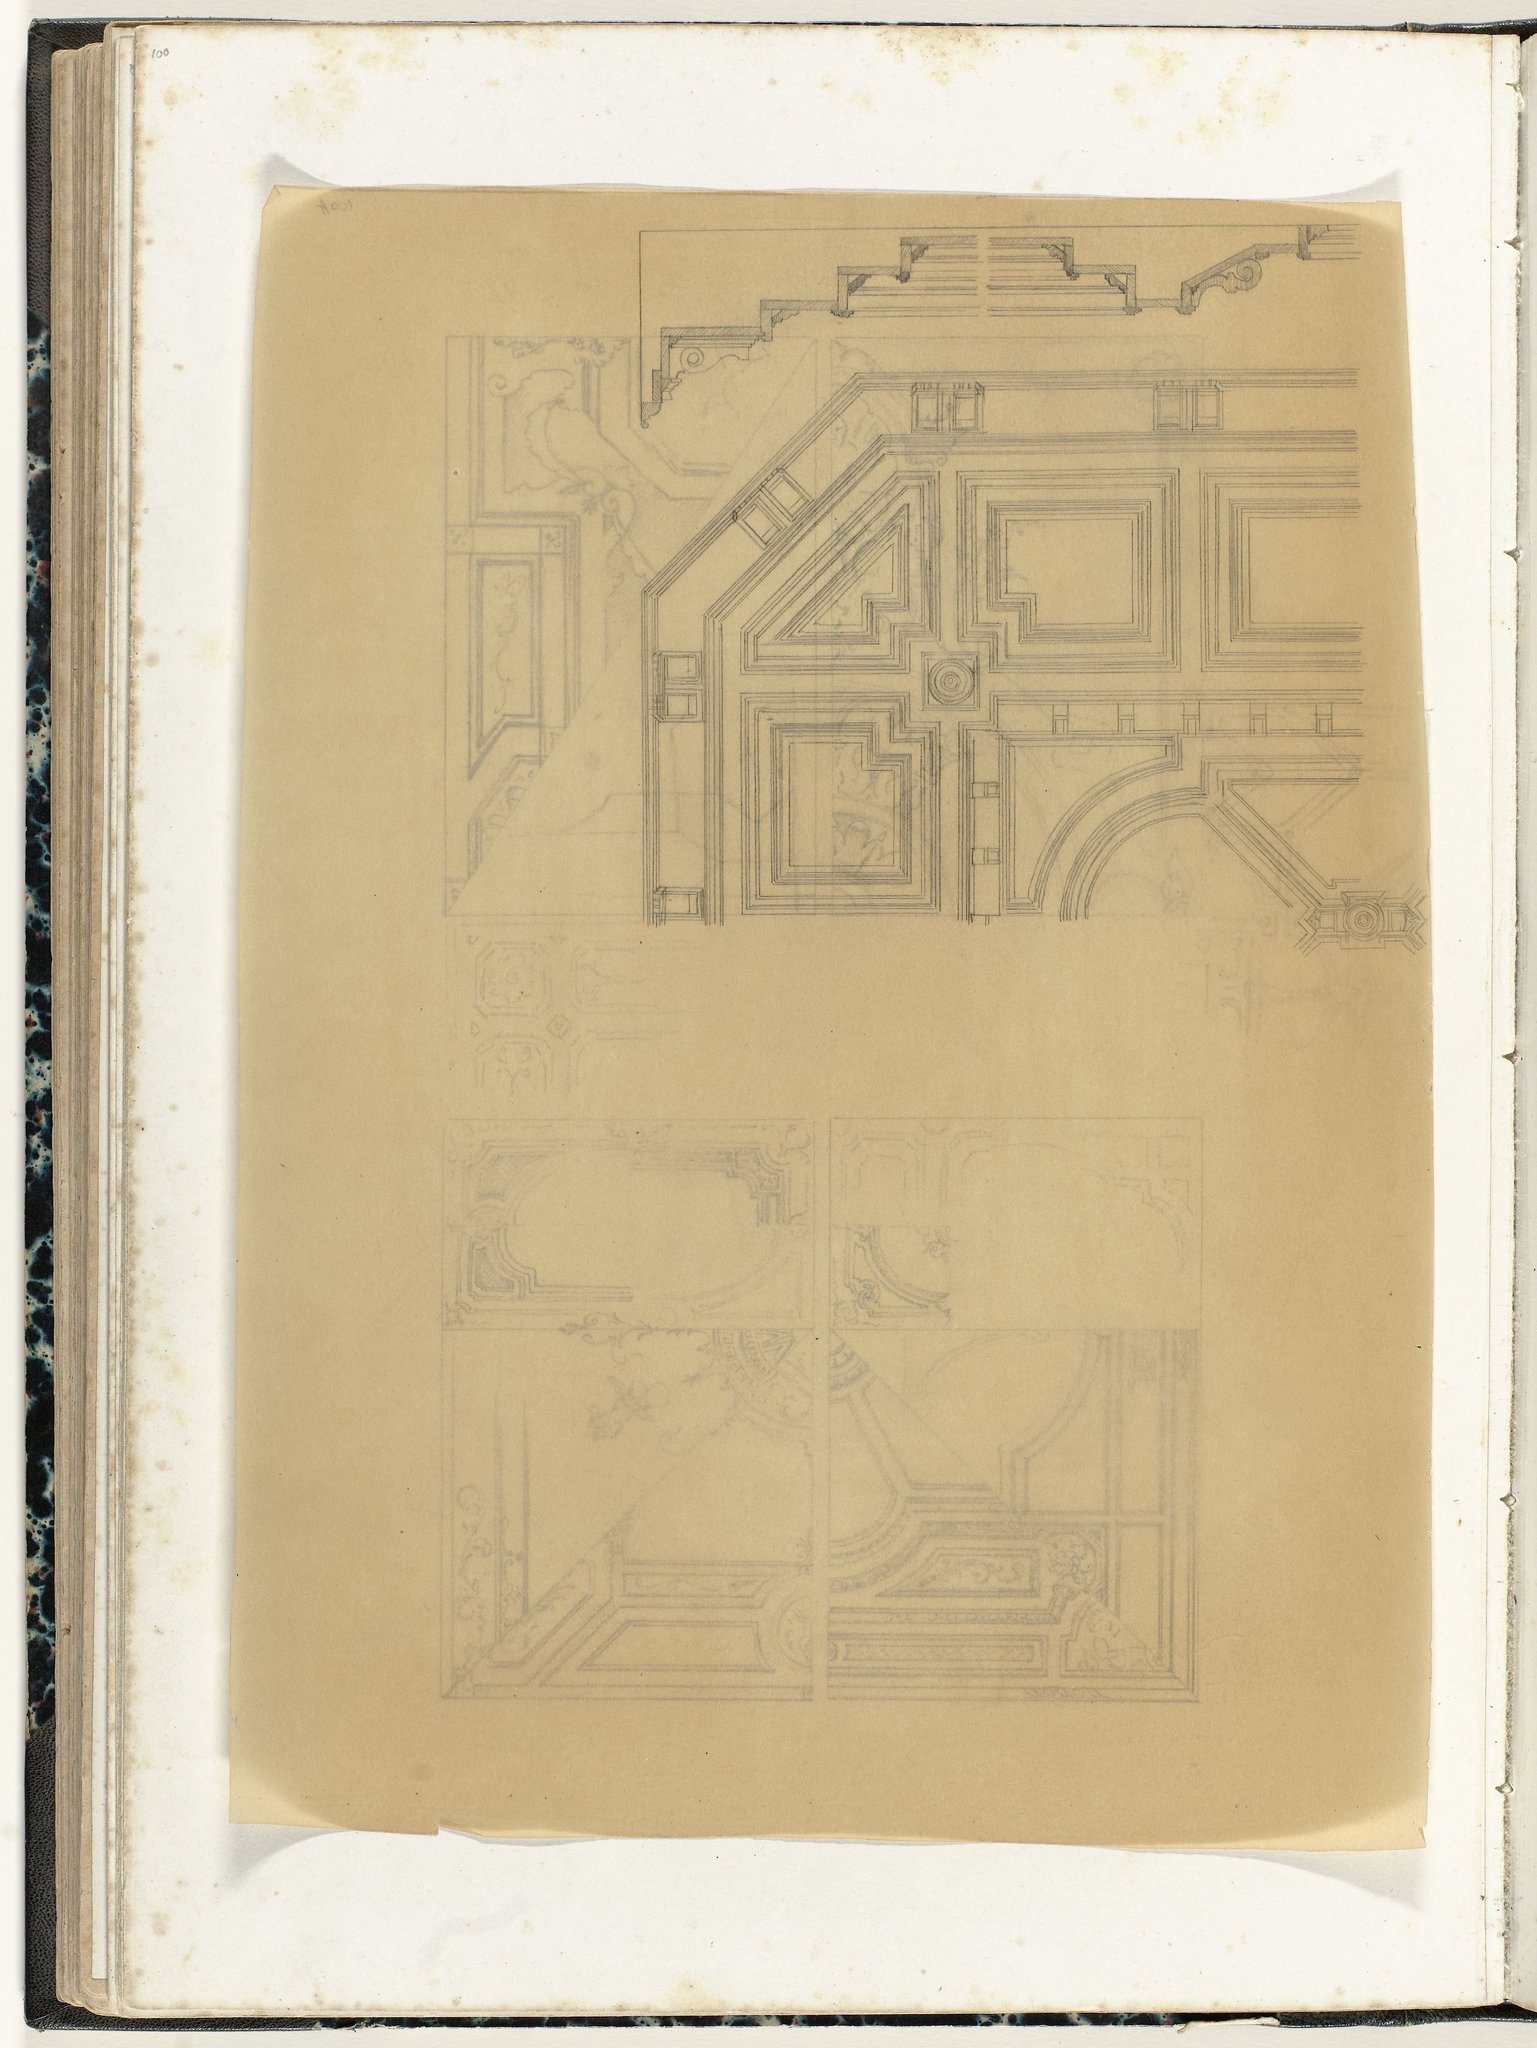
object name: drawing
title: Plafond met detail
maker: Anonymous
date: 1866-1900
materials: pencil, paper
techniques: drawing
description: Kwart van achthoekig plafond met daarboven een detail.